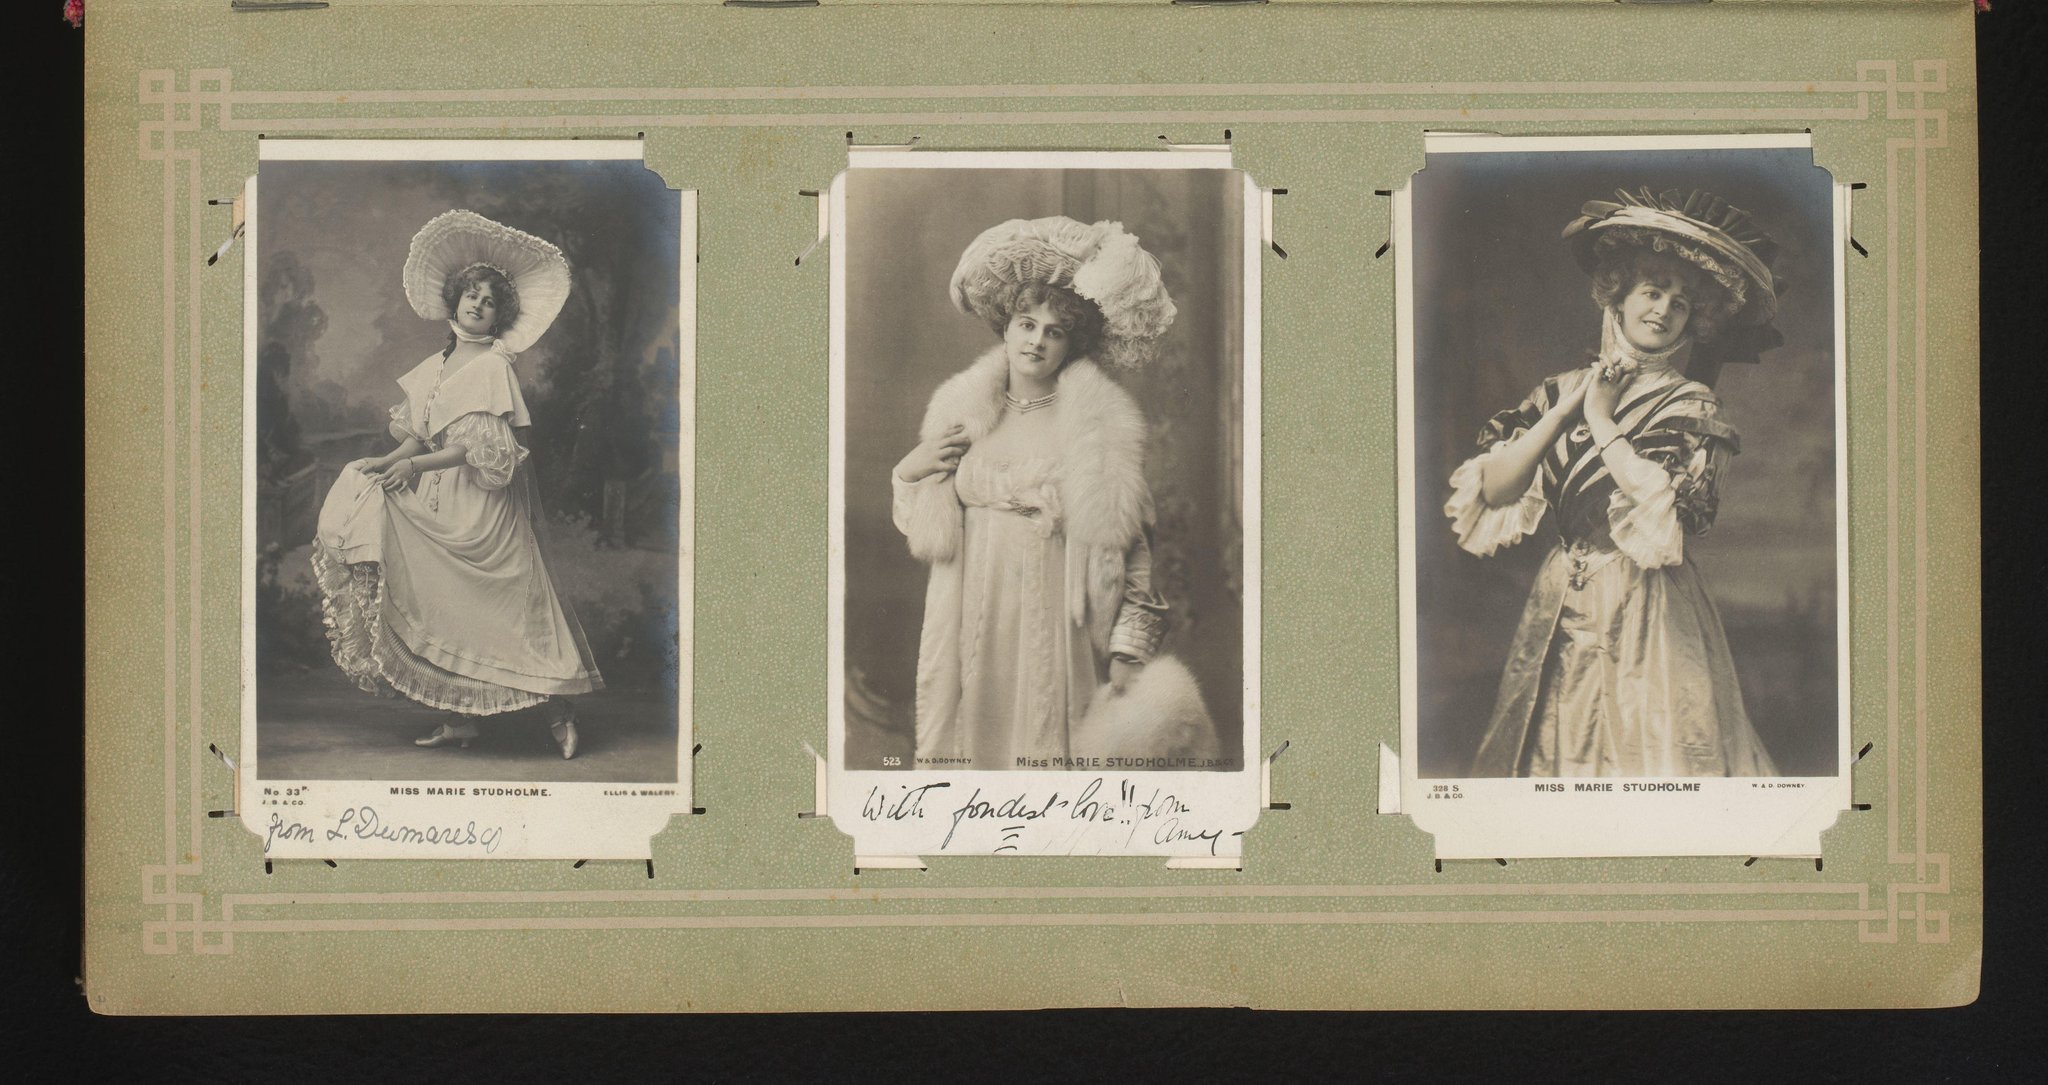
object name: ansichtkaart, prentbriefkaart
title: Drie portretten van Marie Studholme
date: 1900-1930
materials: cardboard, ink, photographic support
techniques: gelatin silver print, pen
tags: historical persons - bb - woman, portrait of actor, actress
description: Deze foto's maken deel uit van een album.